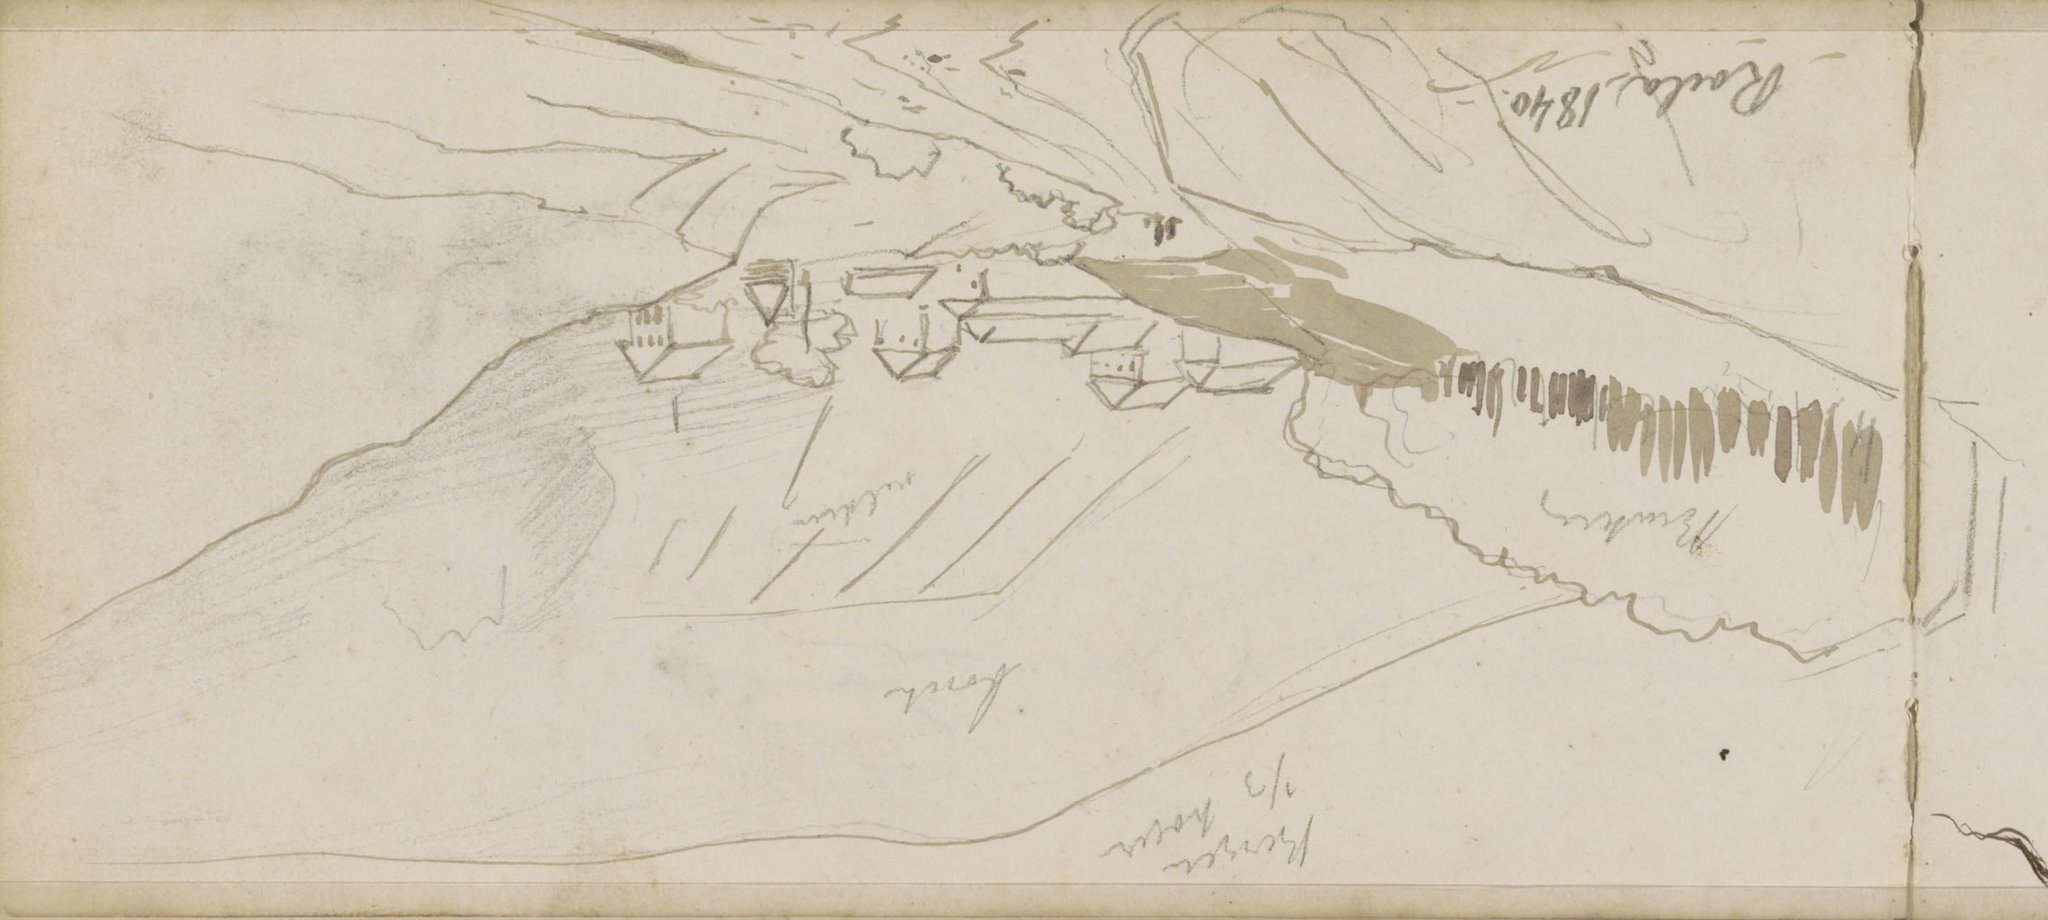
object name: sketchbook leaf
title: Dorp in een berglandschap in Ruhla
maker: johannes tavenraat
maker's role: draughtsman, painter, print maker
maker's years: 1809-1881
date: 1840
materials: ink, paper, pencil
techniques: pen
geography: ruhla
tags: city-view, and landscape with man-made constructions, mountains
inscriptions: date and inscription: ‘Roela 1840’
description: Blad 62 verso uit een schetsboek met 63 bladen.